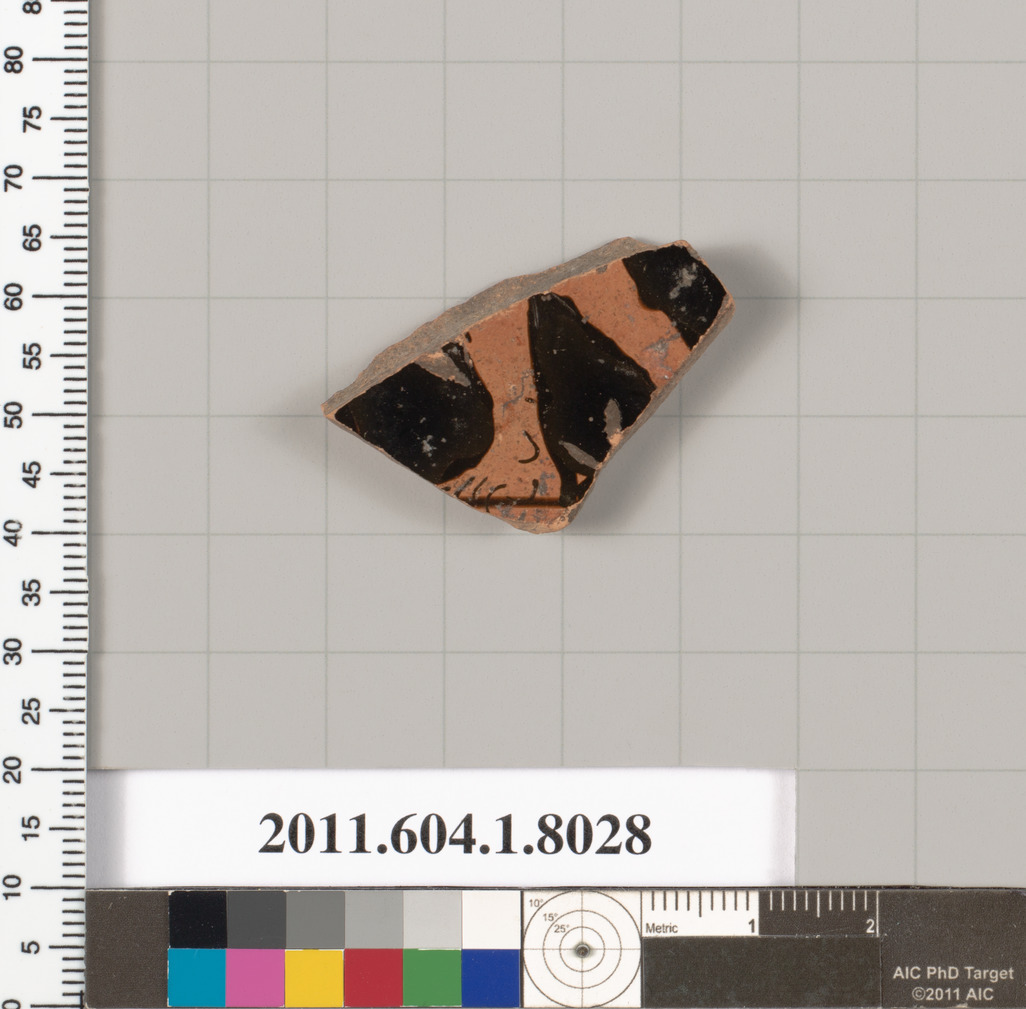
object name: kylix fragment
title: Terracotta fragment of a kylix (drinking cup)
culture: greek, attic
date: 467-435 BCE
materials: terracotta